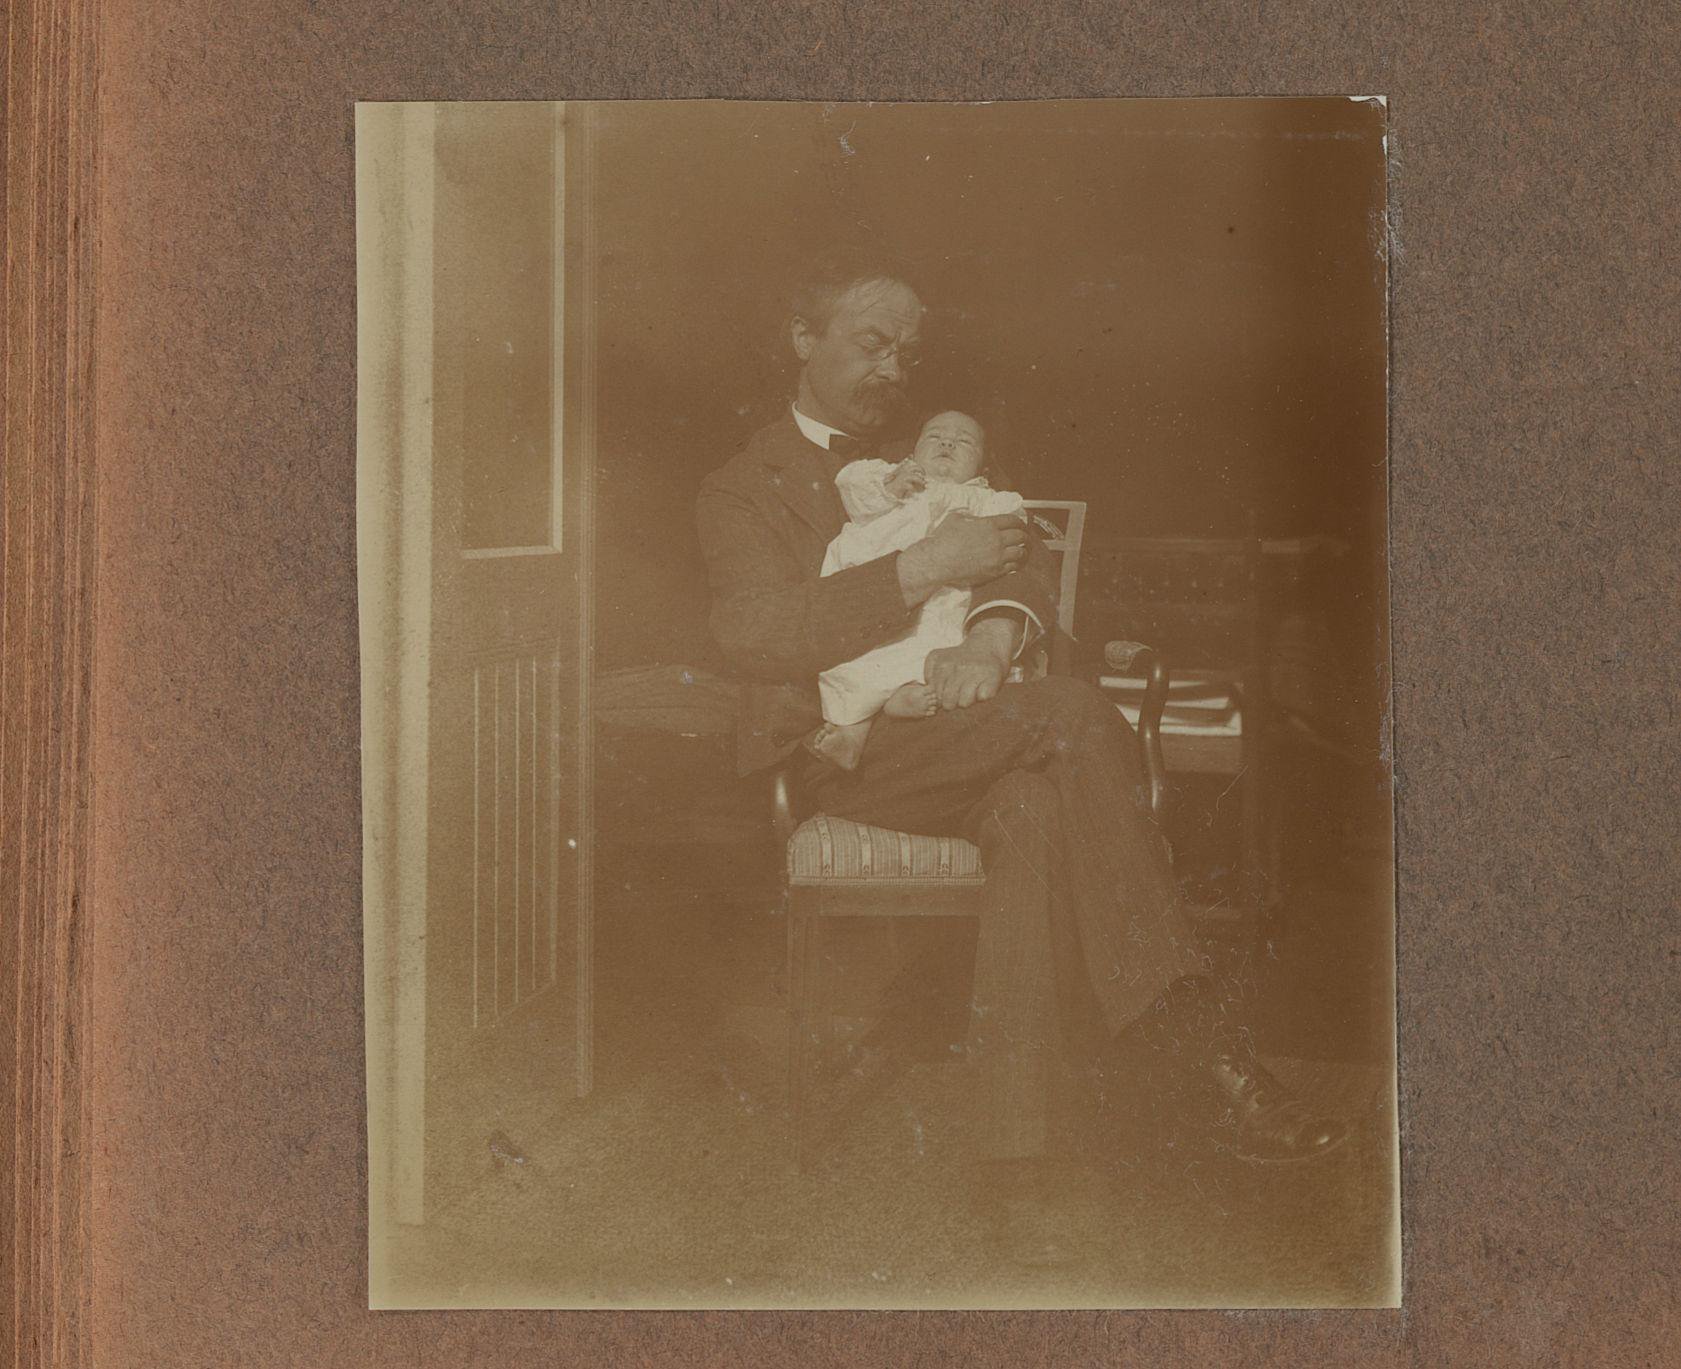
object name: photograph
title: Alphons Diepenbrock met baby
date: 1870-1920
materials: photographic support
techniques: photography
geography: netherlands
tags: amsterdam, alphons diepenbrock, netherlands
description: Foto op bruin albumblad 42 van familiealbum van Alphons Diepenbrock.